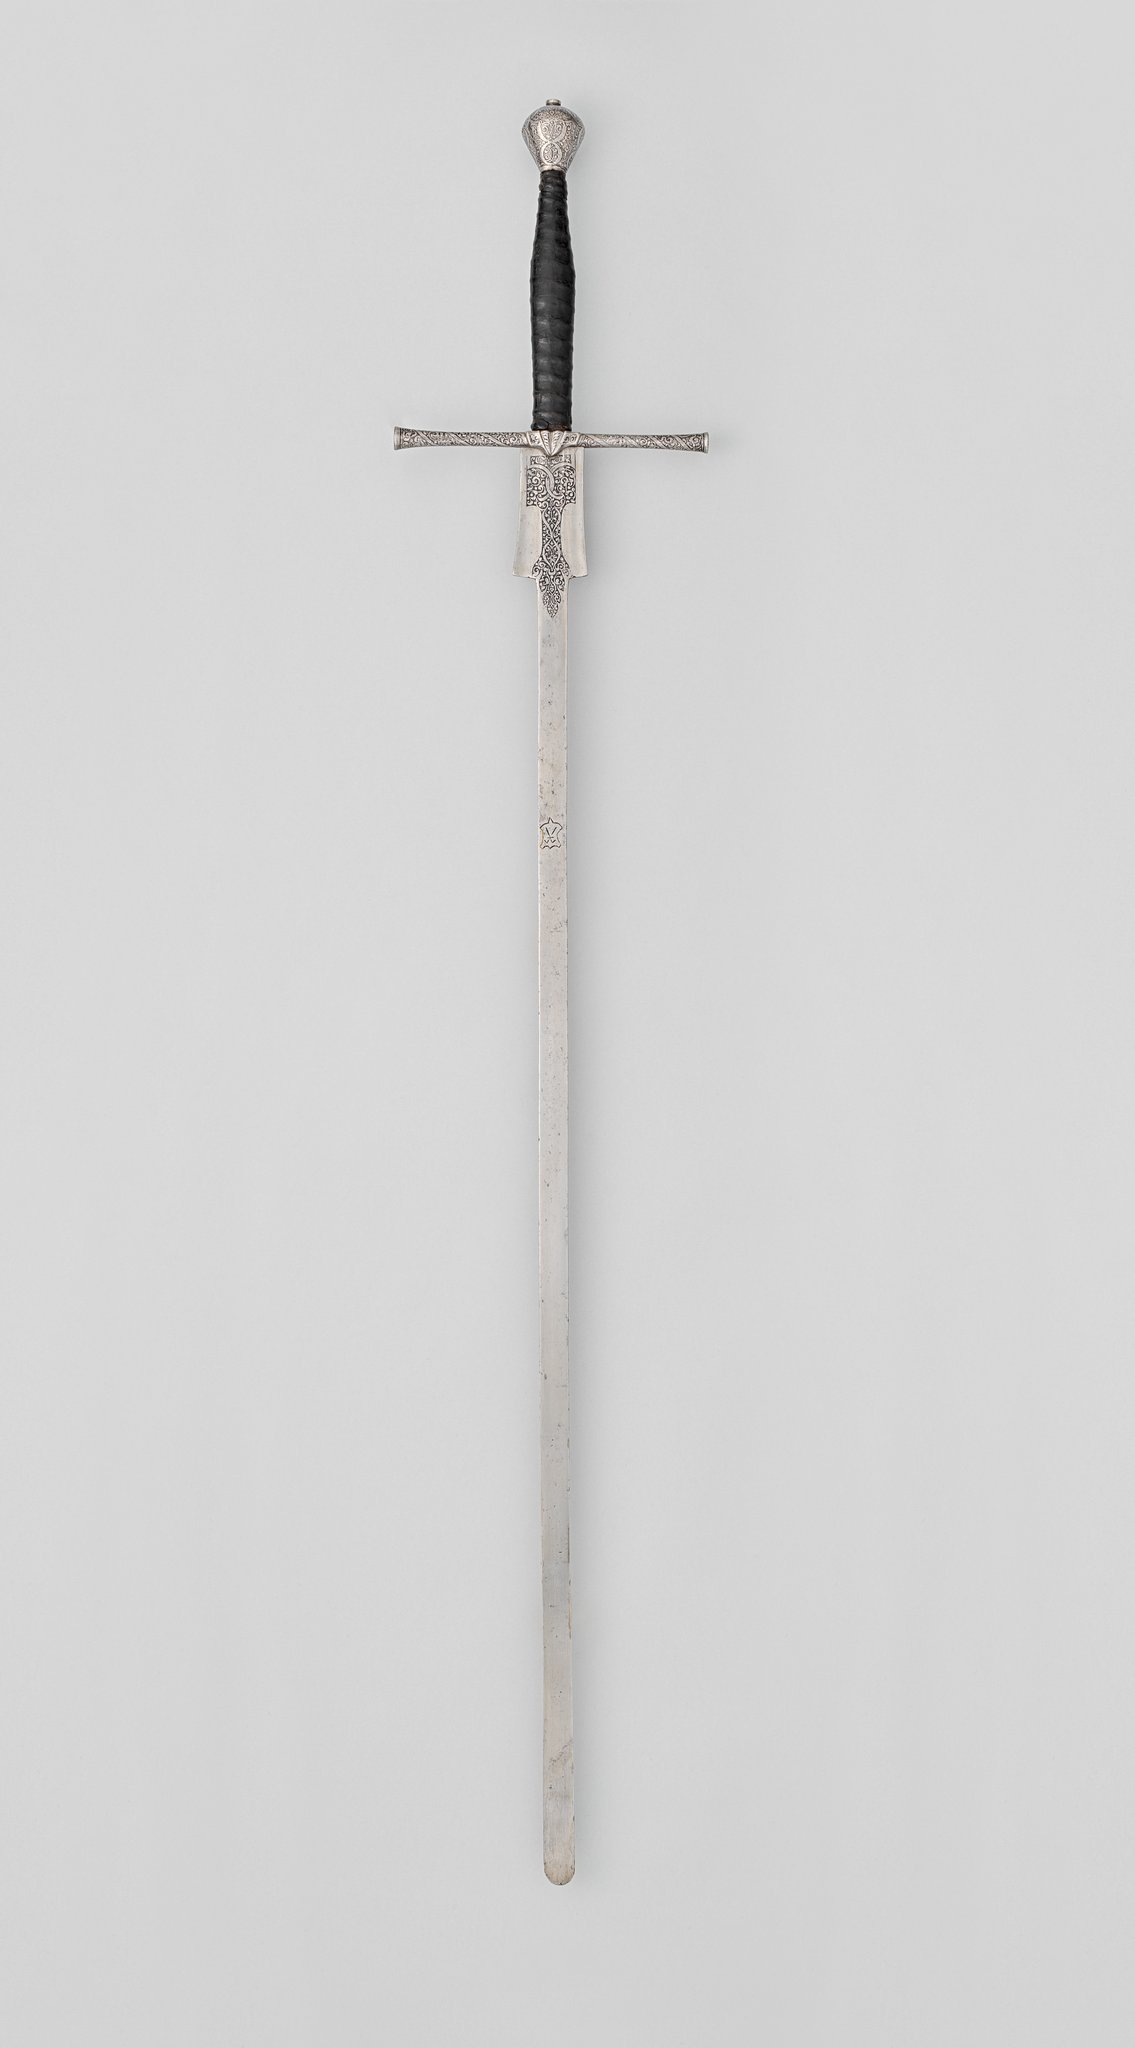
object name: practice sword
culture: german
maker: ulrich diefstetter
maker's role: bladesmith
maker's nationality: german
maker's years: 1536-1589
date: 1575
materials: brass, leather, steel, wood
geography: germany